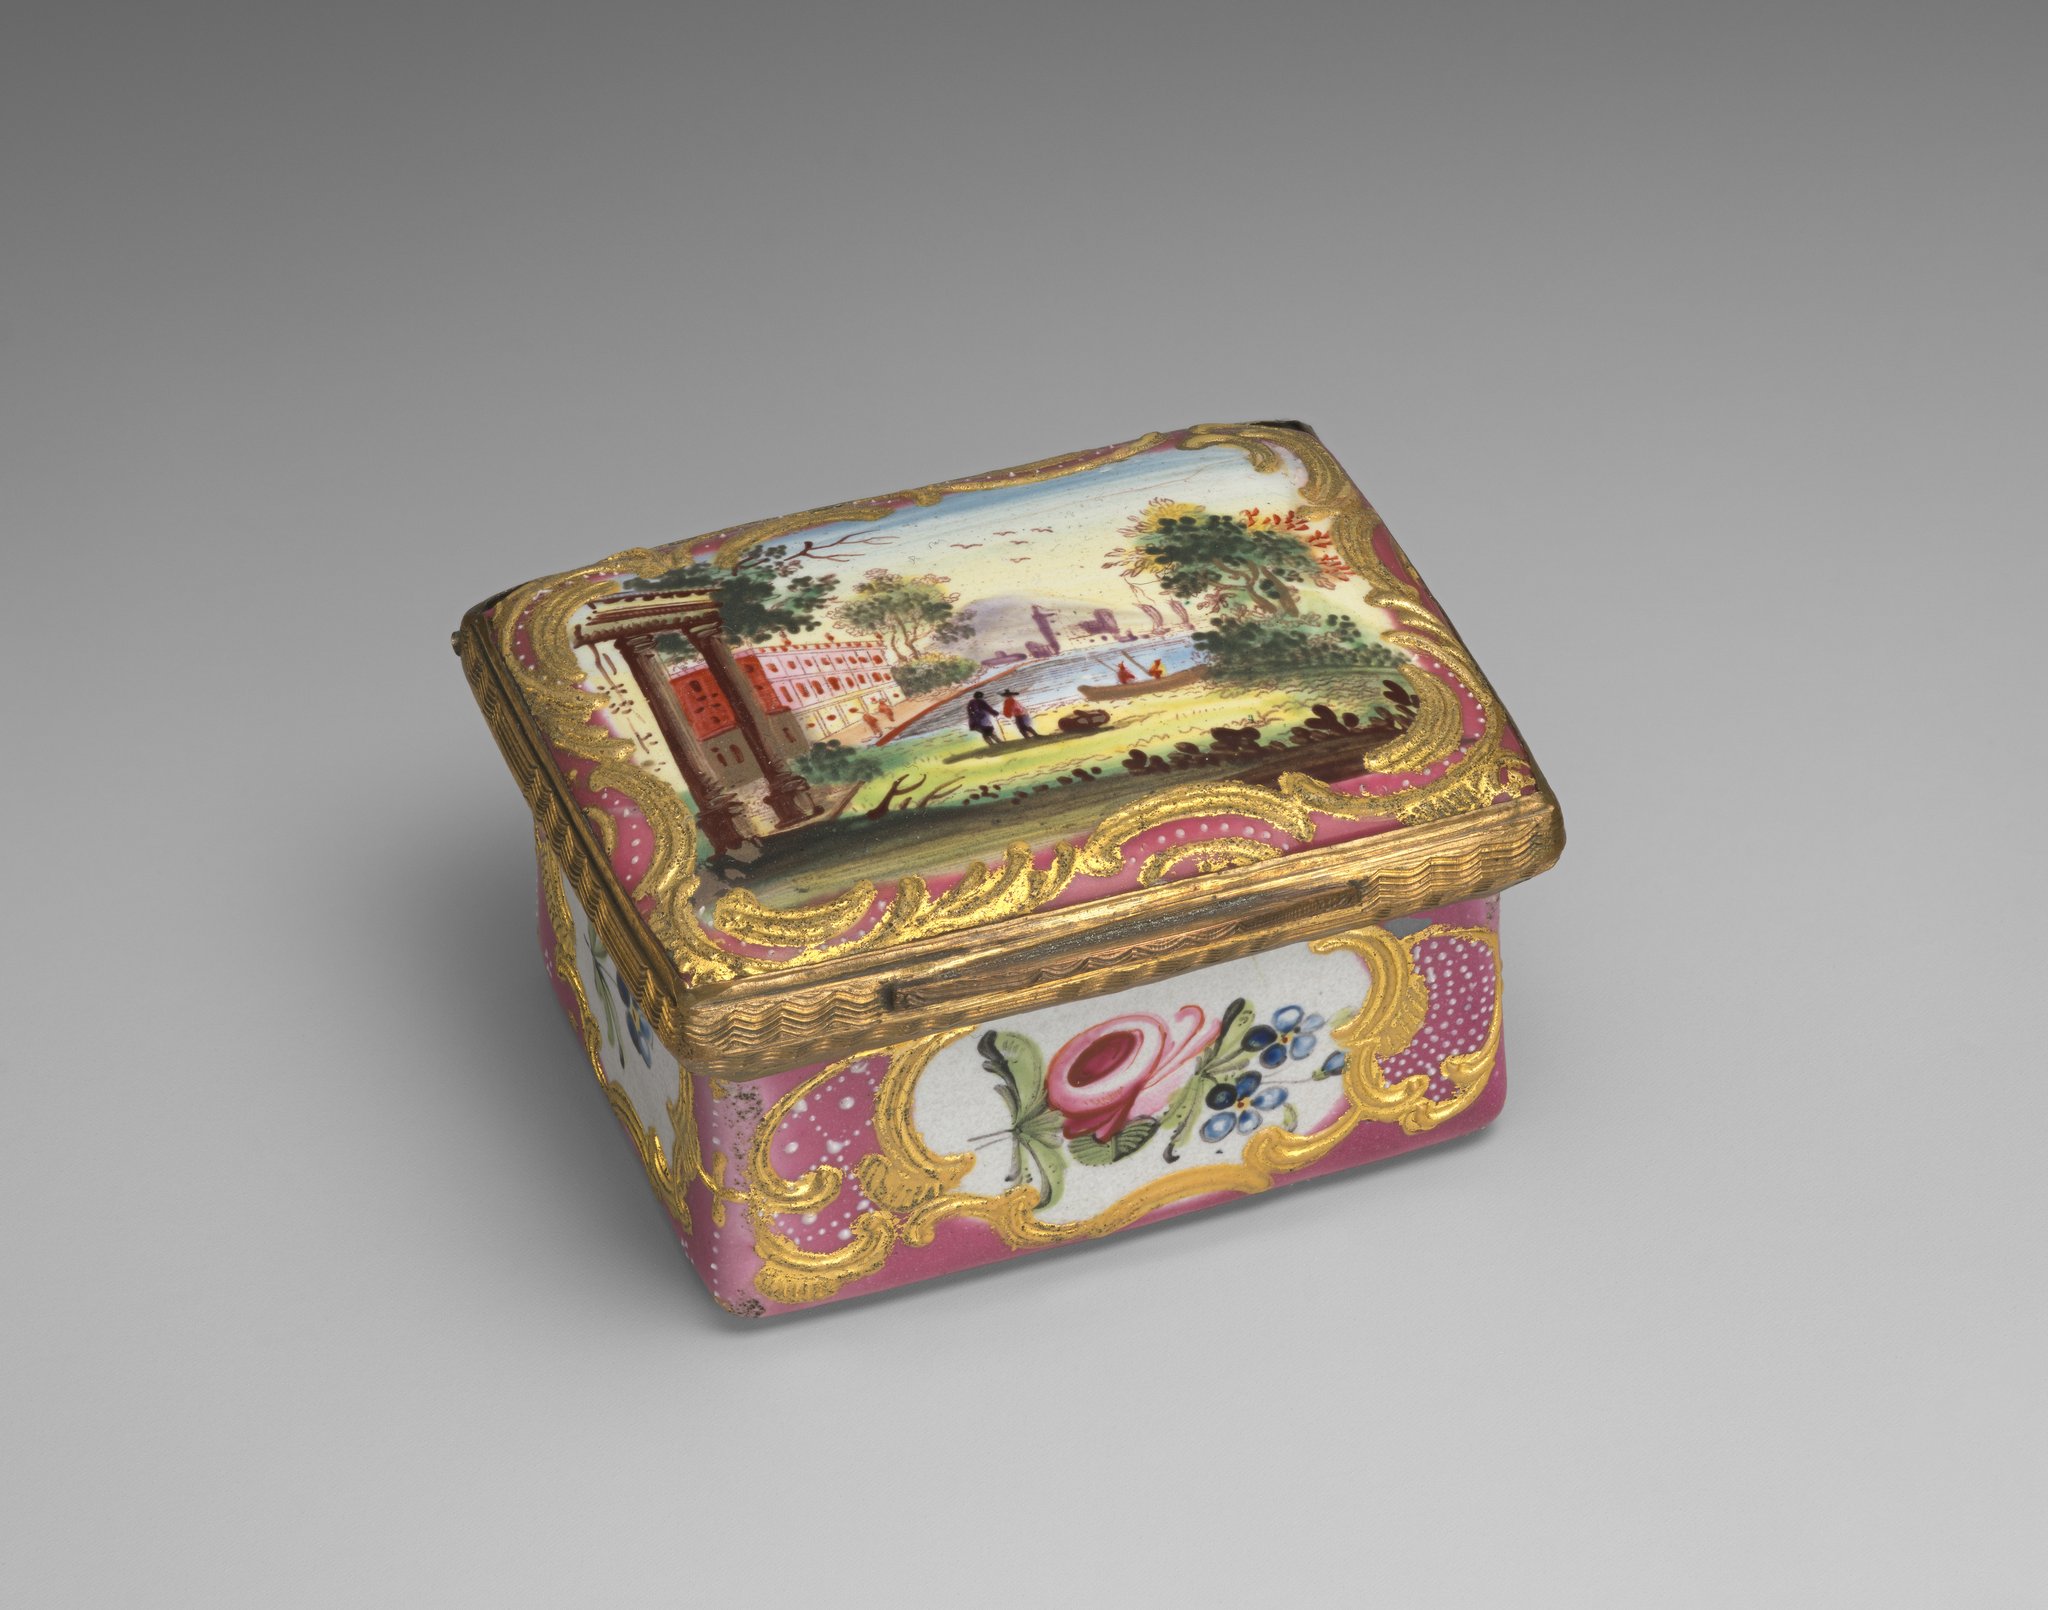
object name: snuffbox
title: Snuffbox inscribed “L'Amour Vainqueur” [Love Conquers]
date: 1765-1770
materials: copper, enamel